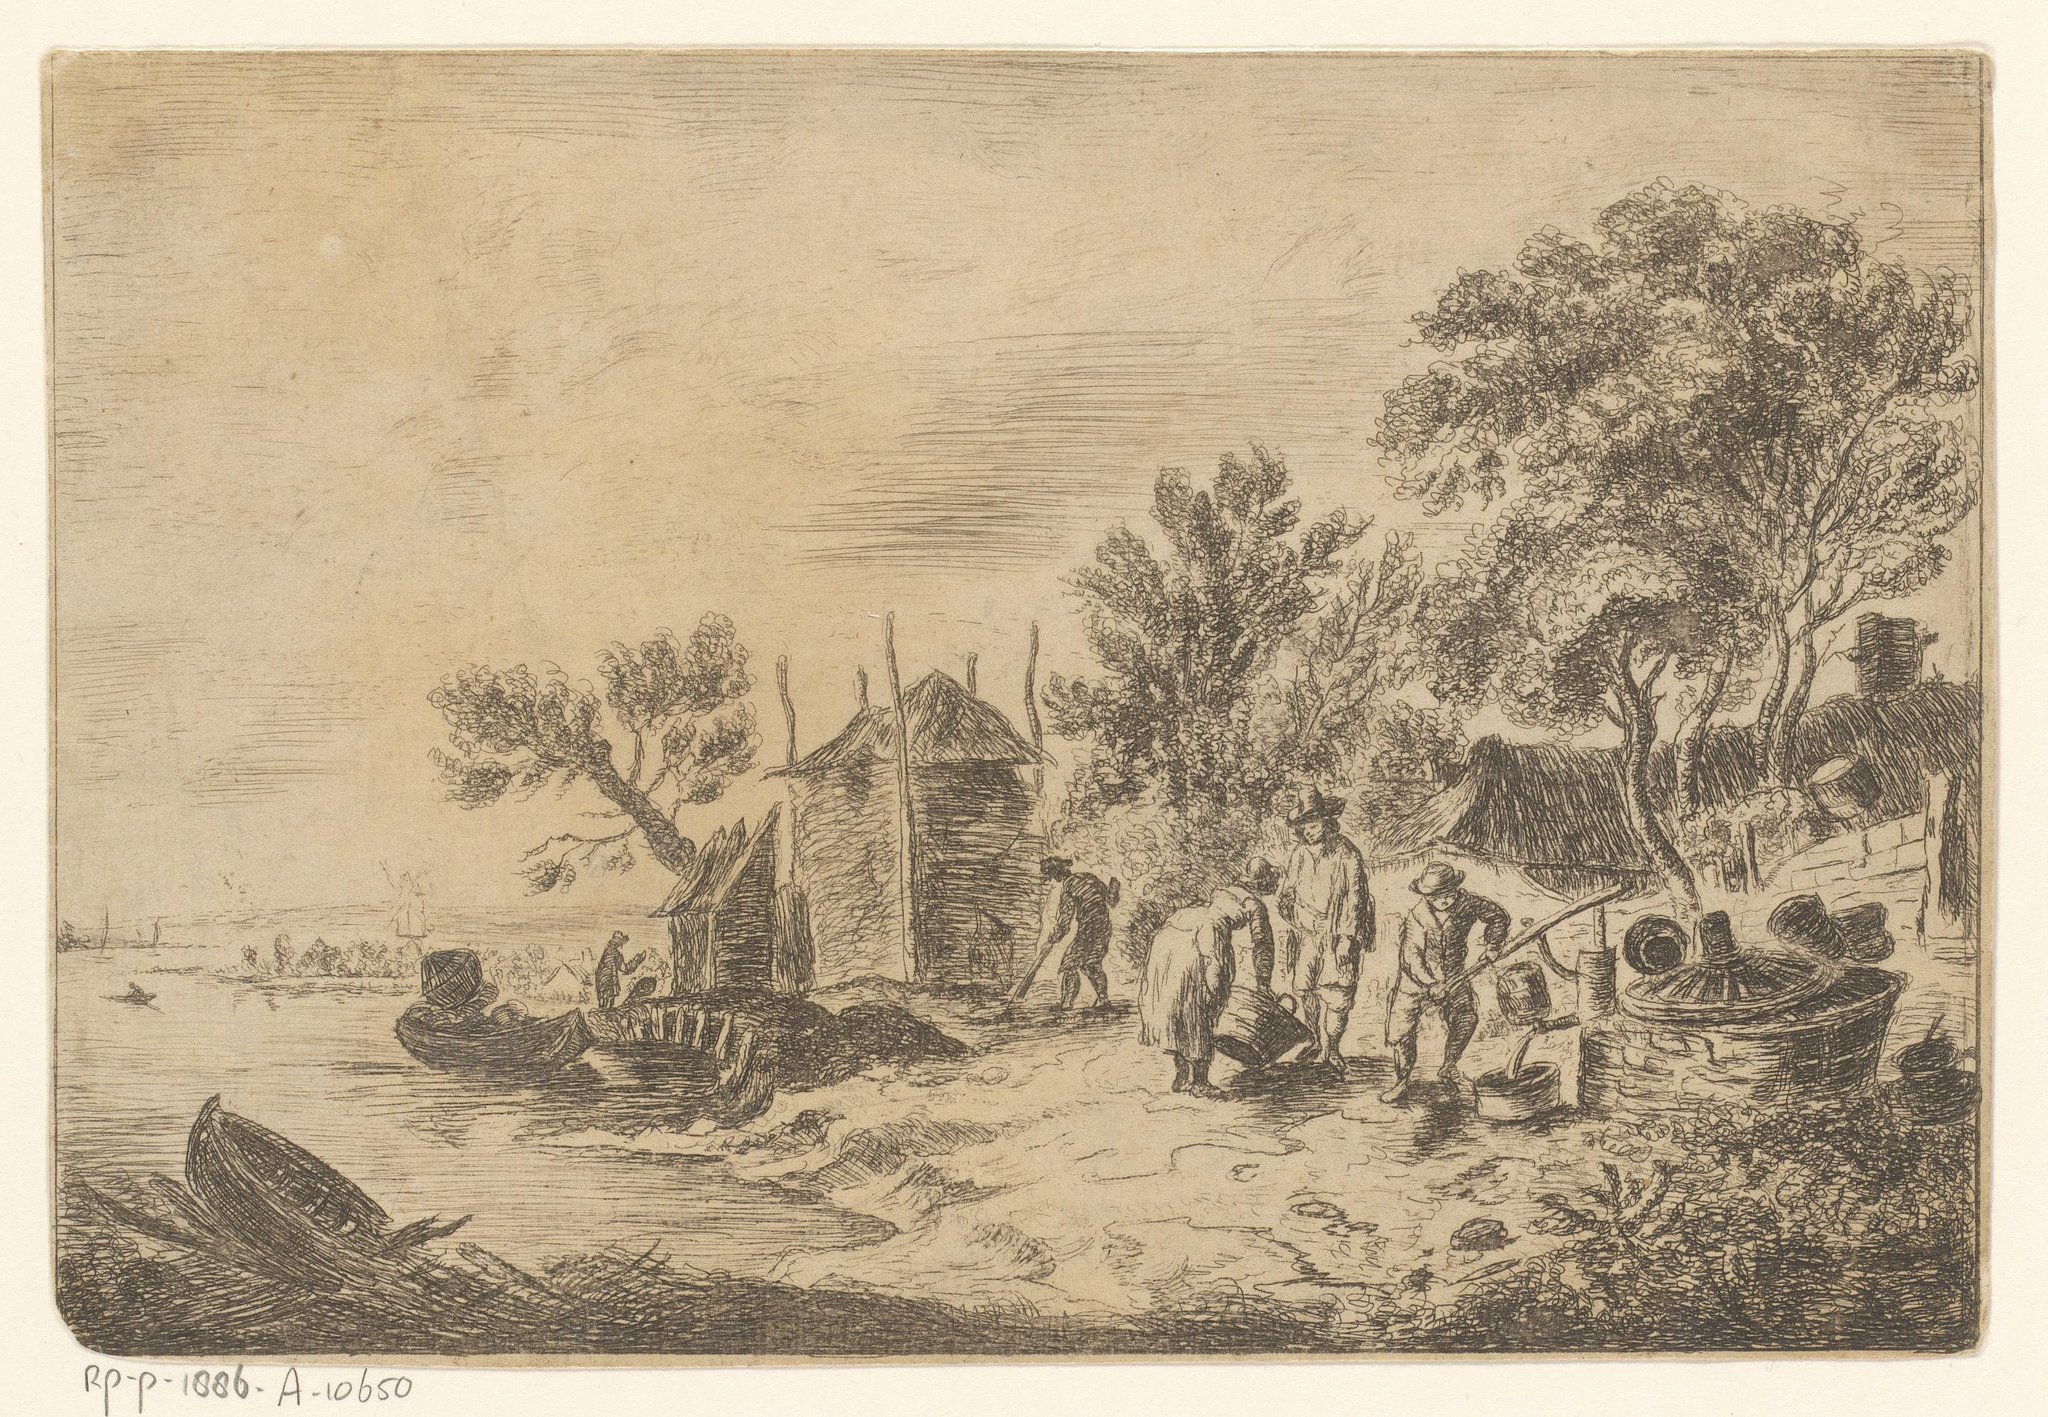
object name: print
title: Bedrijvigheid langs de waterkant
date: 1650-1698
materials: paper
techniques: etching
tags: river, hay-stack, farm or solitary house in landscape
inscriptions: collector's mark: Lugt 2228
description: Landschap met een rivier. Op de kant een vrouw die de inhoud van een tobbe aan een man met hoed toont. Rechts een man die water pompt. Midden achter een hooiberg.